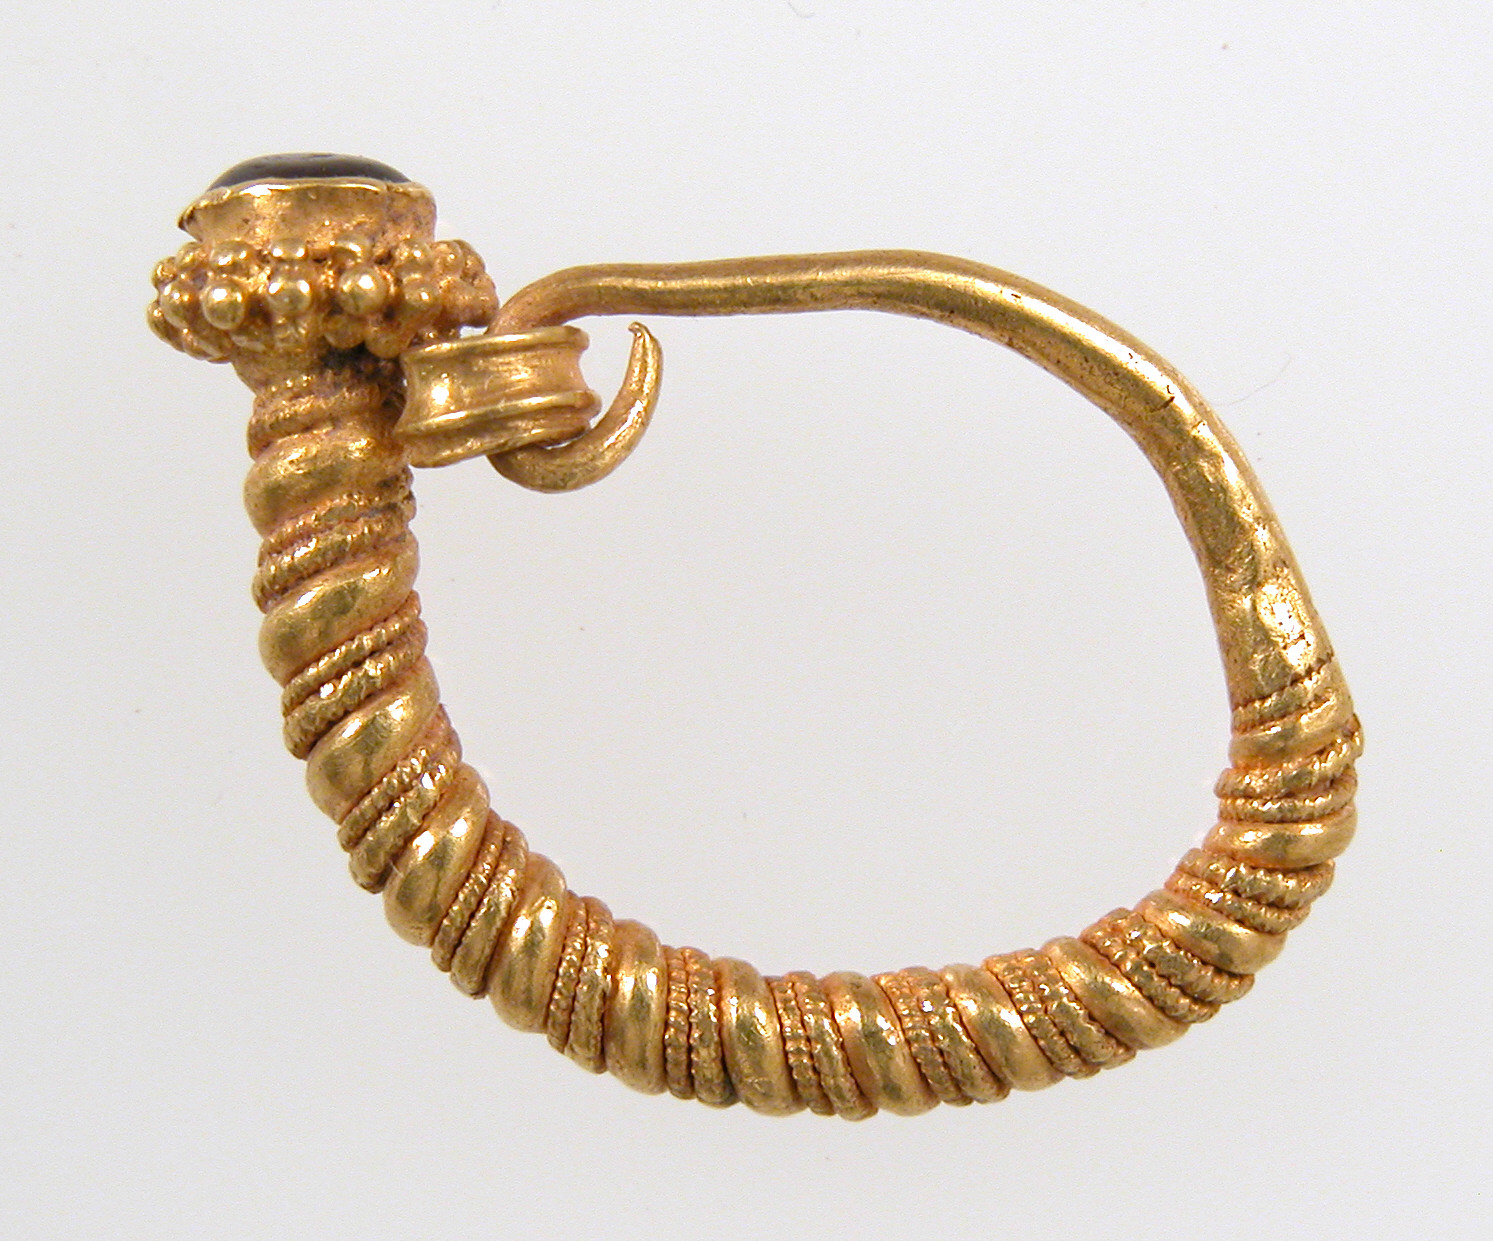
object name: earring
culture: pontine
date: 201-300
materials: gemstone, glass, gold, paste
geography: northern france